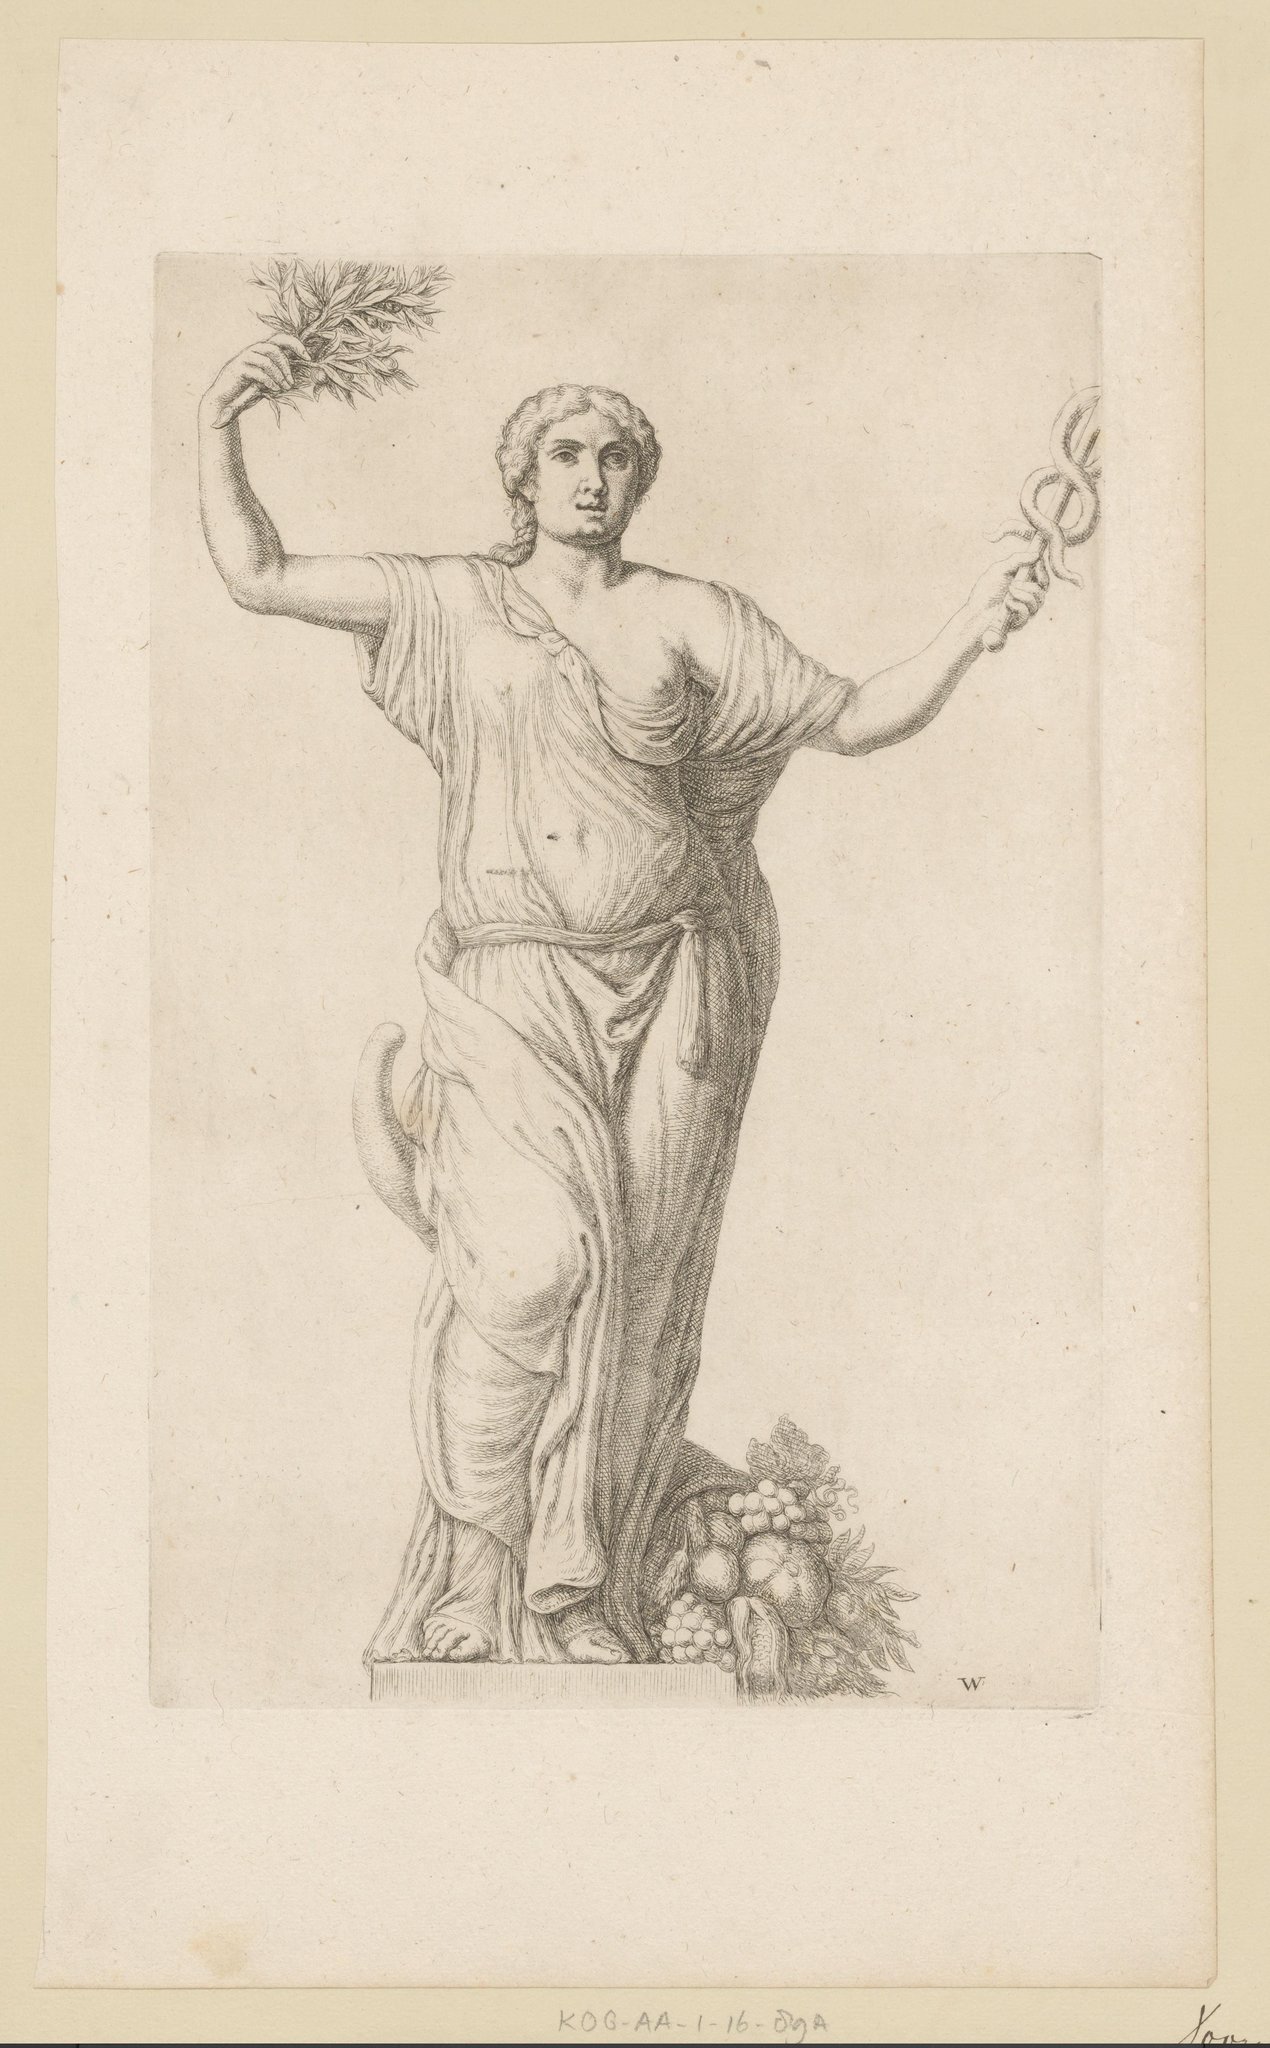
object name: print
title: Beeld van Pax (Vrede) op de voorgevel van het Stadhuis op de Dam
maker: hubert quellinus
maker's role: print maker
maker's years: 1619-1687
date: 1663-1668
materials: paper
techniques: engraving, etching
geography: amsterdam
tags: 'cornucopia', horn of plenty, symbols, allegories of peace, 'pax'; 'pace' (ripa), townhall, caduceus (staff with two snakes, attribute of mercury), pax as roman personification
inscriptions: collector's mark: ‘16,89’ Lugt 1641b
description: Prent gebruikt in: Secunca pars Praecipuarum effigierum ac ornamentorum amplissime Curiae Amstelrodamensis maiori ex parte in cadido marmore effectorum per Artum Quellinium eiusdem Civitatis Statuarium / Het tweede deel Van de voornaemste Statuen ende Cieraten van 't konst-rijcke Stadt-huys van Amstelredam 'tmeeste in Marmer gemaeckt door Artus Quellinus Beelthouwer der voorseyde Stadt. Amsterdam: Artus Quellinus (I), 1663. En in: Secunca pars Praecipuarum effigierum ac ornamentorum amplissime Curiae Amstelrodamensis maiori ex parte in cadido marmore effectorum per Artum Quellinium eiusdem Civitatis Statuarium / Het tweede deel Van de voornaemste Statuen ende Cieraten van 't konst-rijcke Stadt-huys van Amstelredam 'tmeeste in Marmer gemaeckt door Artus Quellinus Beelthouwer der voorseyde Stadt. Amsterdam: Frederik de Wit, 1668. Latere staat van prent ook gebruikt in: Architecture peinture et sculpture de la Maison de Ville d'Amsterdam, representee en CIX. figures en taille-douce (…). Amsterdam: David Mortier, 1719. En in: Architecture peinture et sculpture de la Maison de Ville d'Amsterdam, representee en CIX. figures en taille-douce (…). Amsterdam: Gerard Valck, 1719. En in: Bouw schilder en beeldhouwkonst, van het Stadhuis te Amsteldam, vertoont in CIX figuuren (…). Amsterdam: Covens & Mortier & Covens Jr., s.a. (1774-1783).